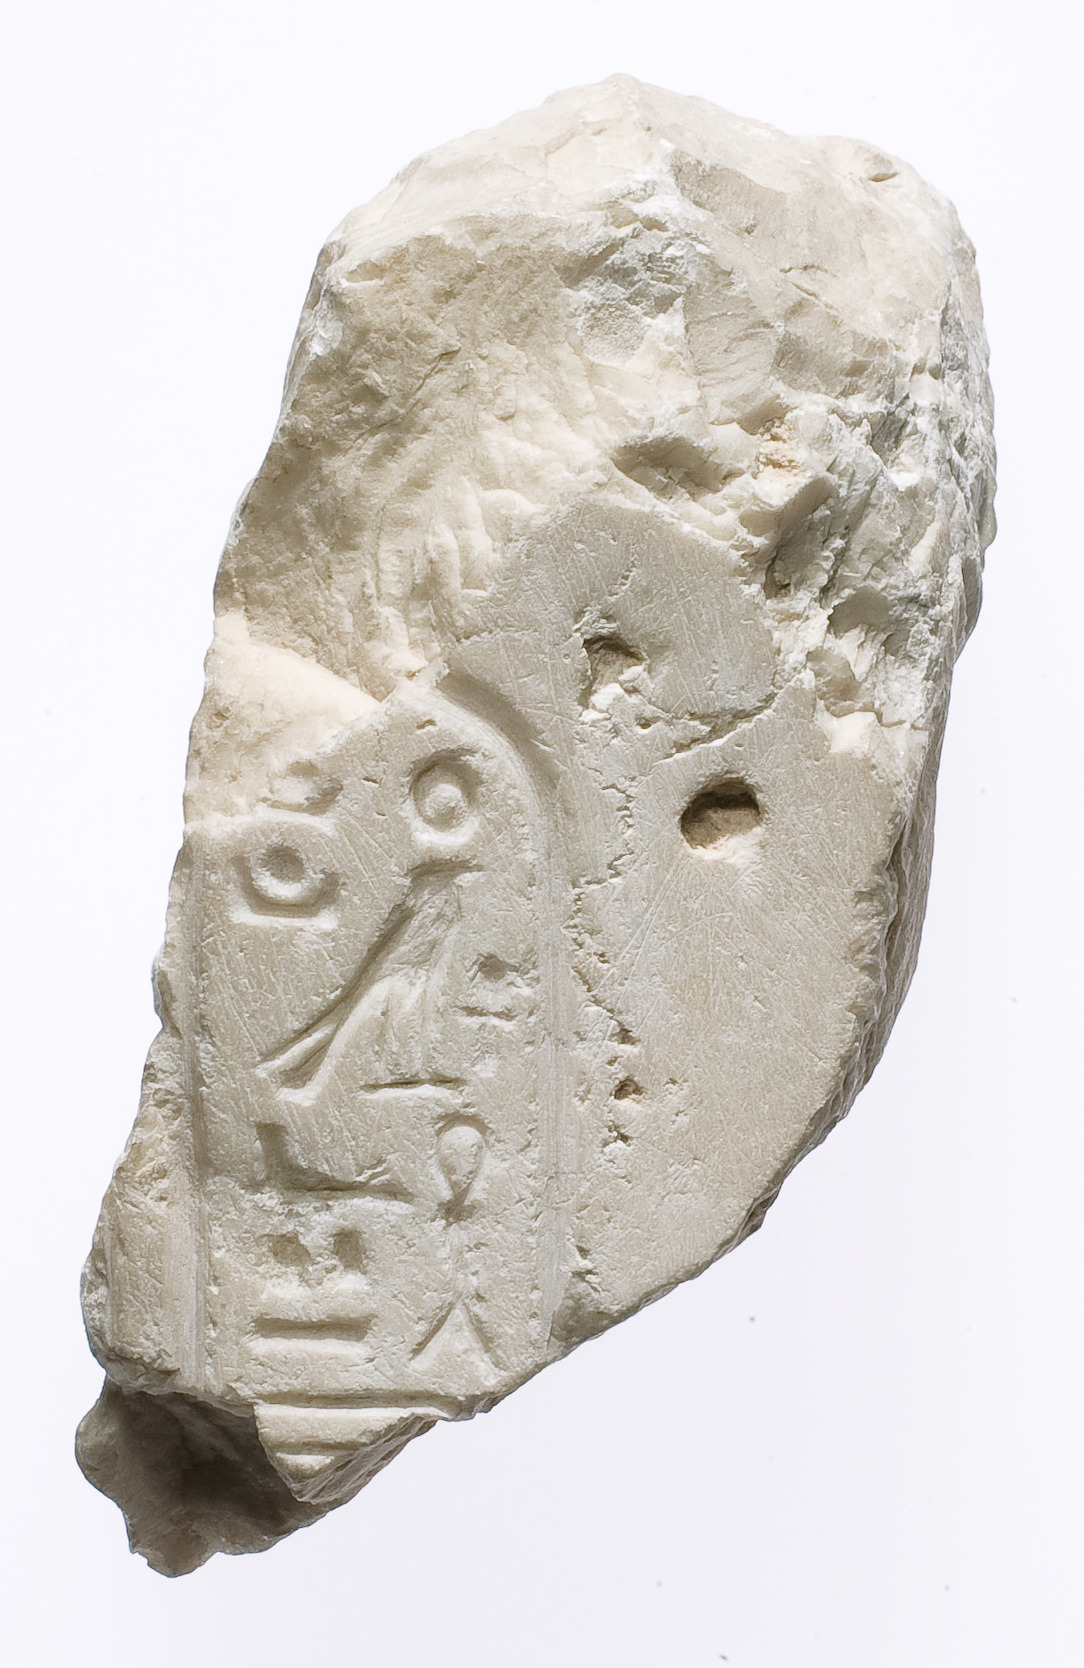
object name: body fragment, cartouche of aten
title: Chest (?) fragment with Aten cartouche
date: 1353-1336 BCE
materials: limestone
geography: egypt